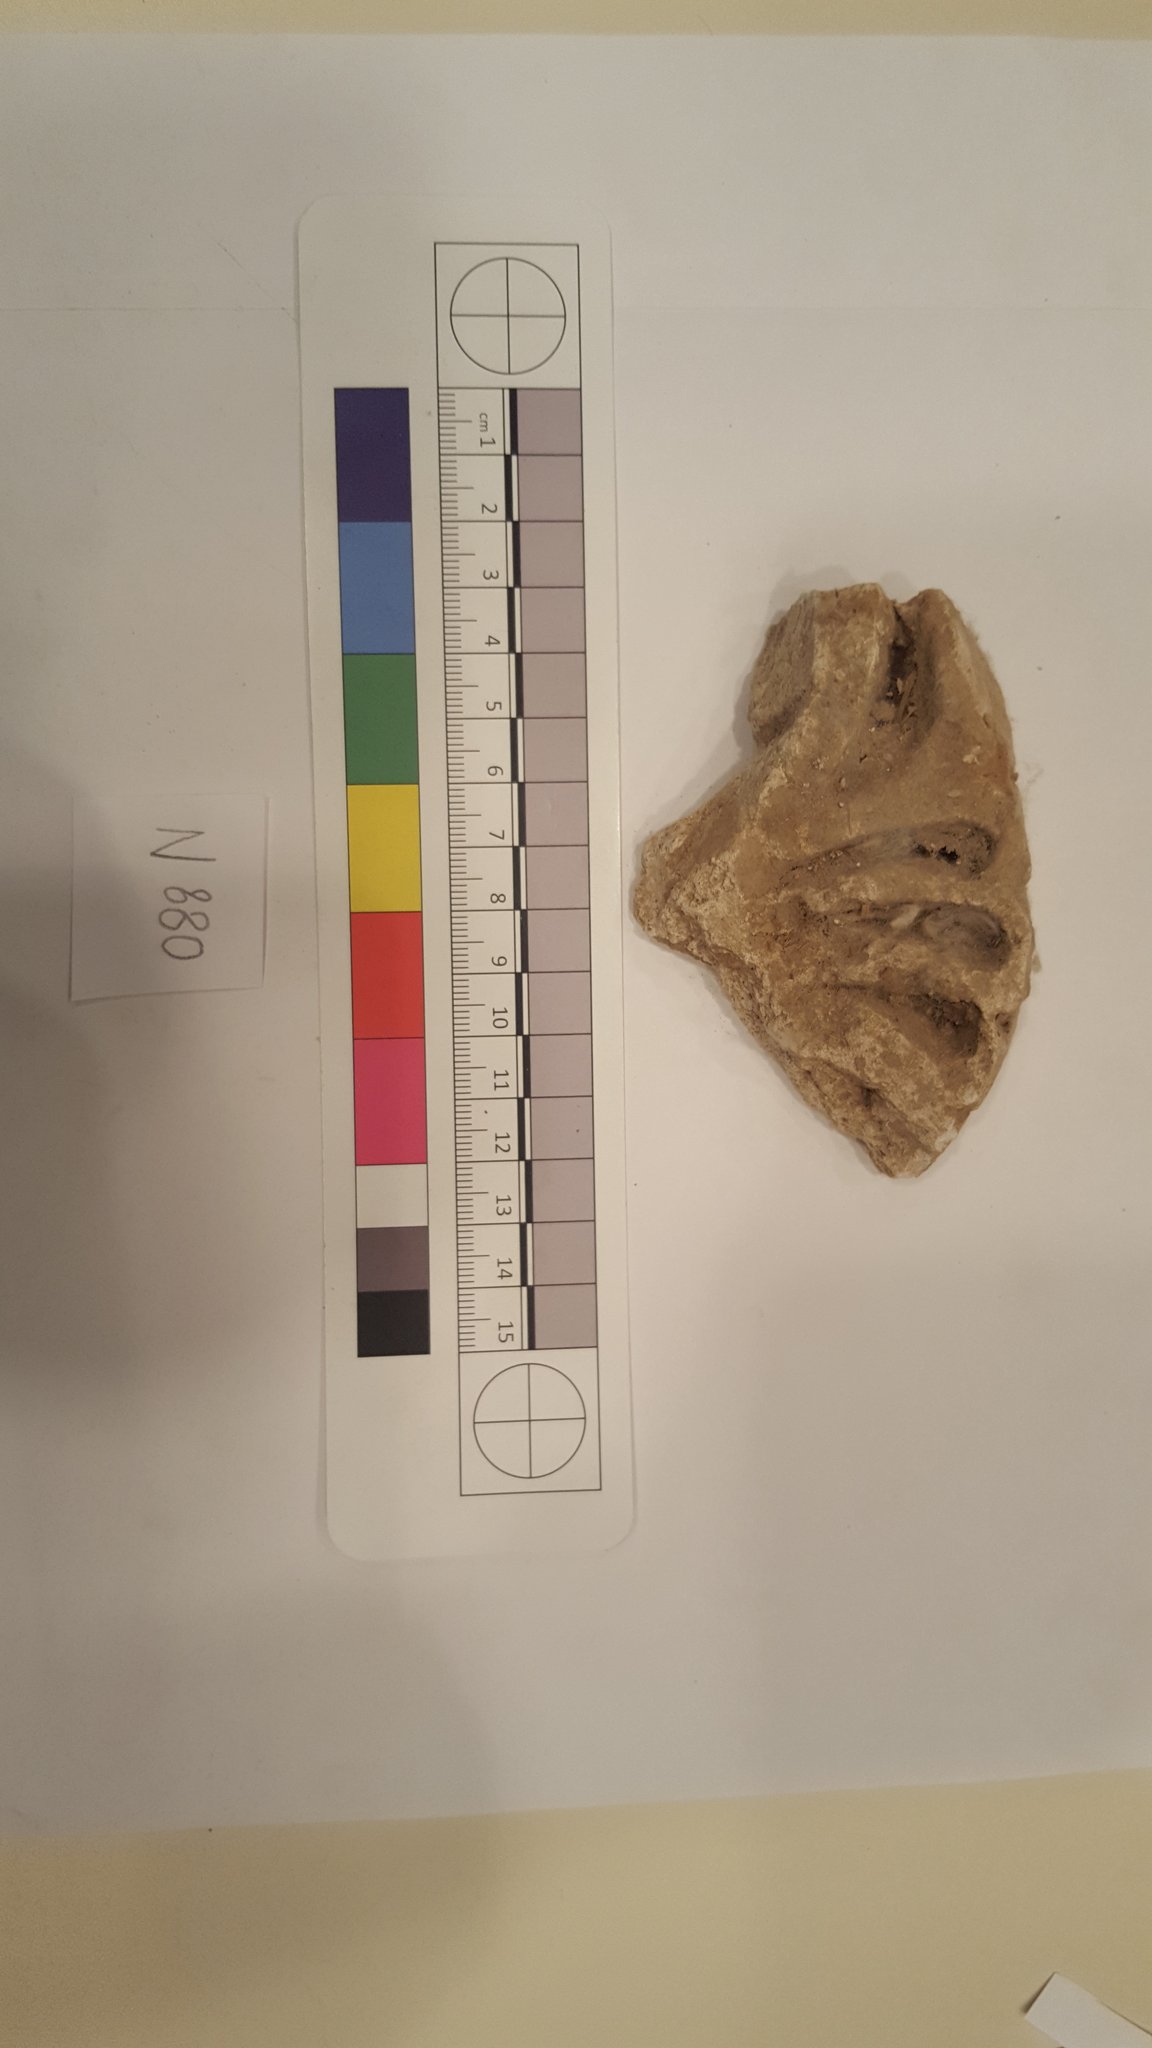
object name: fragment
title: Stucco Fragment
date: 701-1200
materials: plaster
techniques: carving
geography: iran